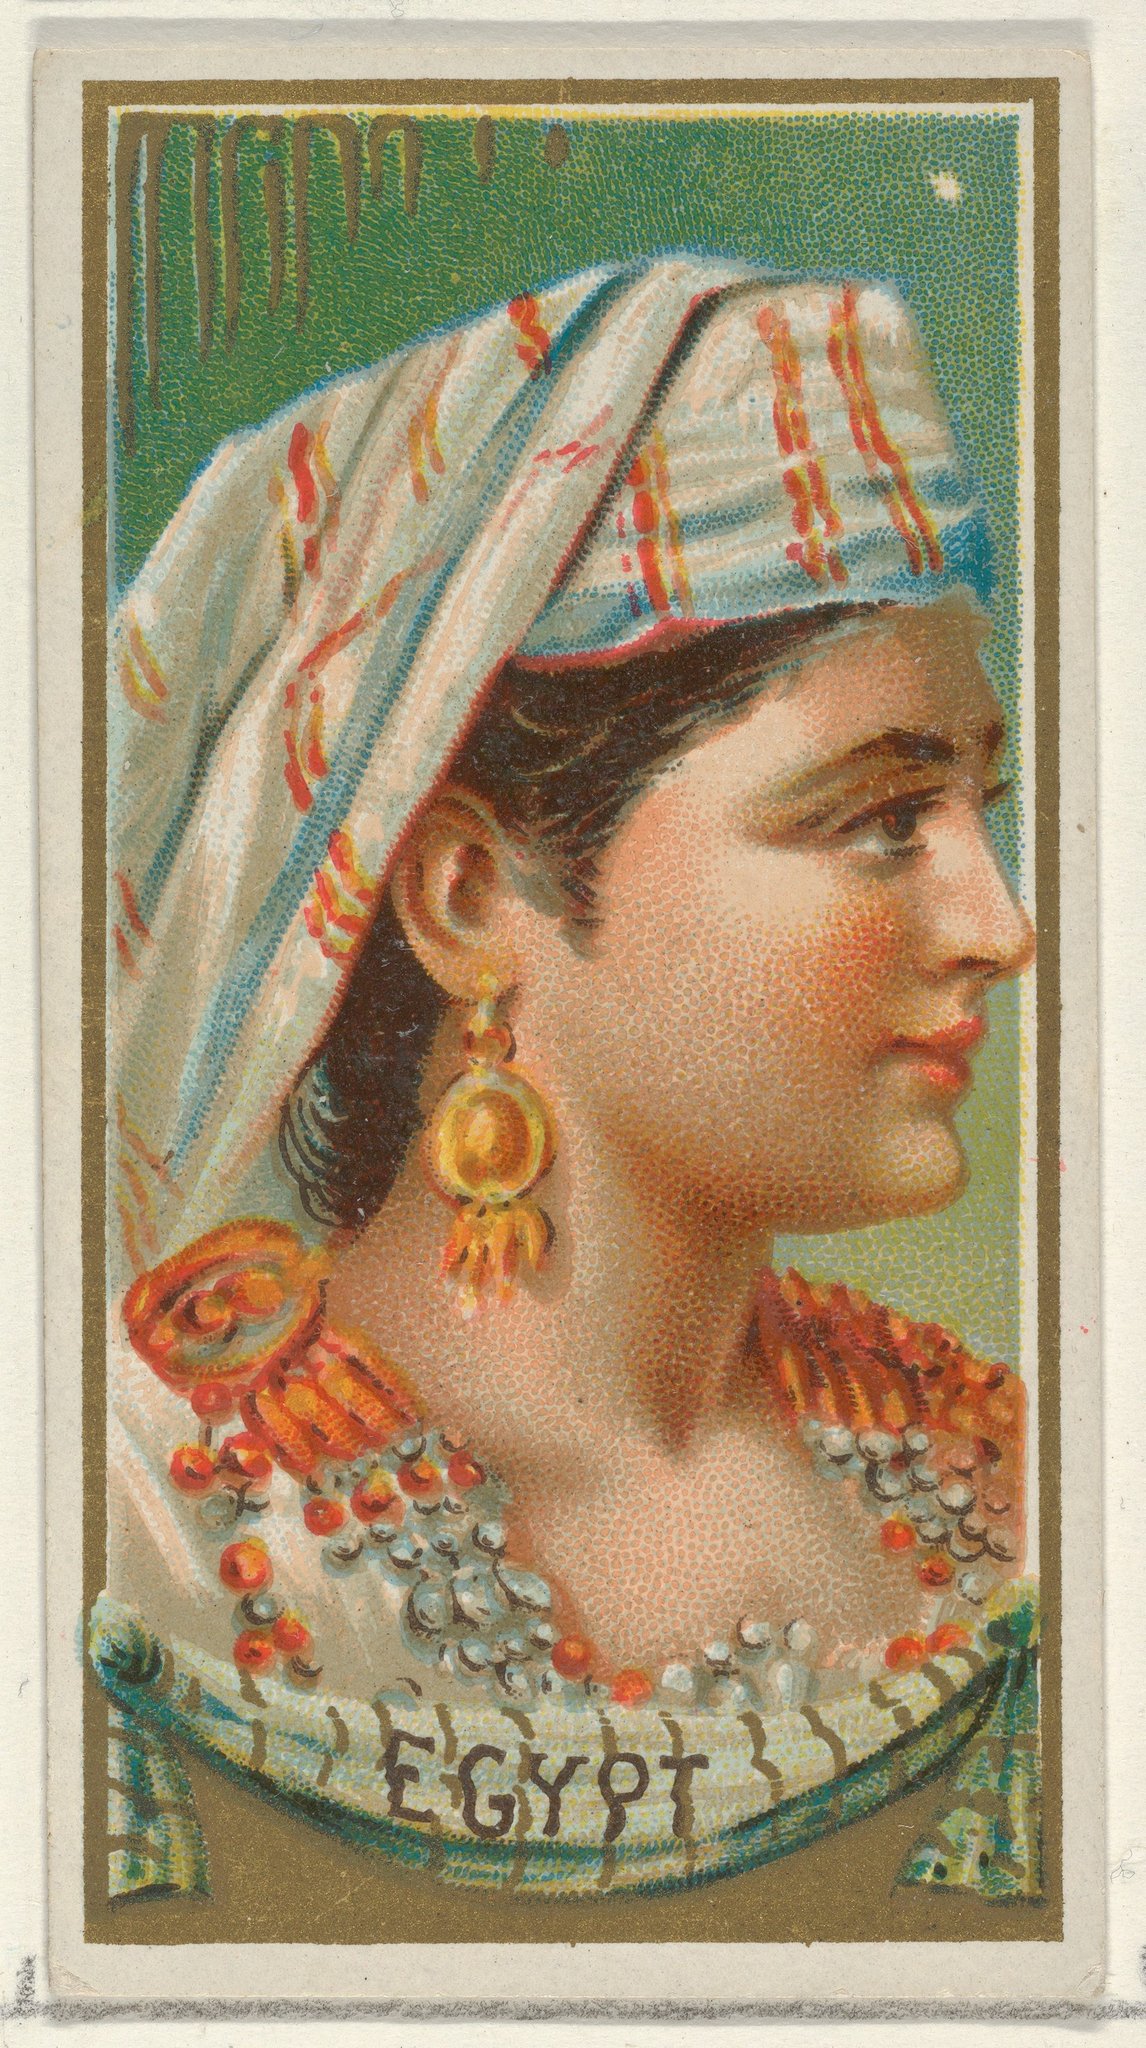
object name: print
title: Egypt, from the Types of All Nations series (N24) for Allen & Ginter Cigarettes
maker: allen & ginter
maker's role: publisher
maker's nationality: american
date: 1889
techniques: color lithograph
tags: profiles,women